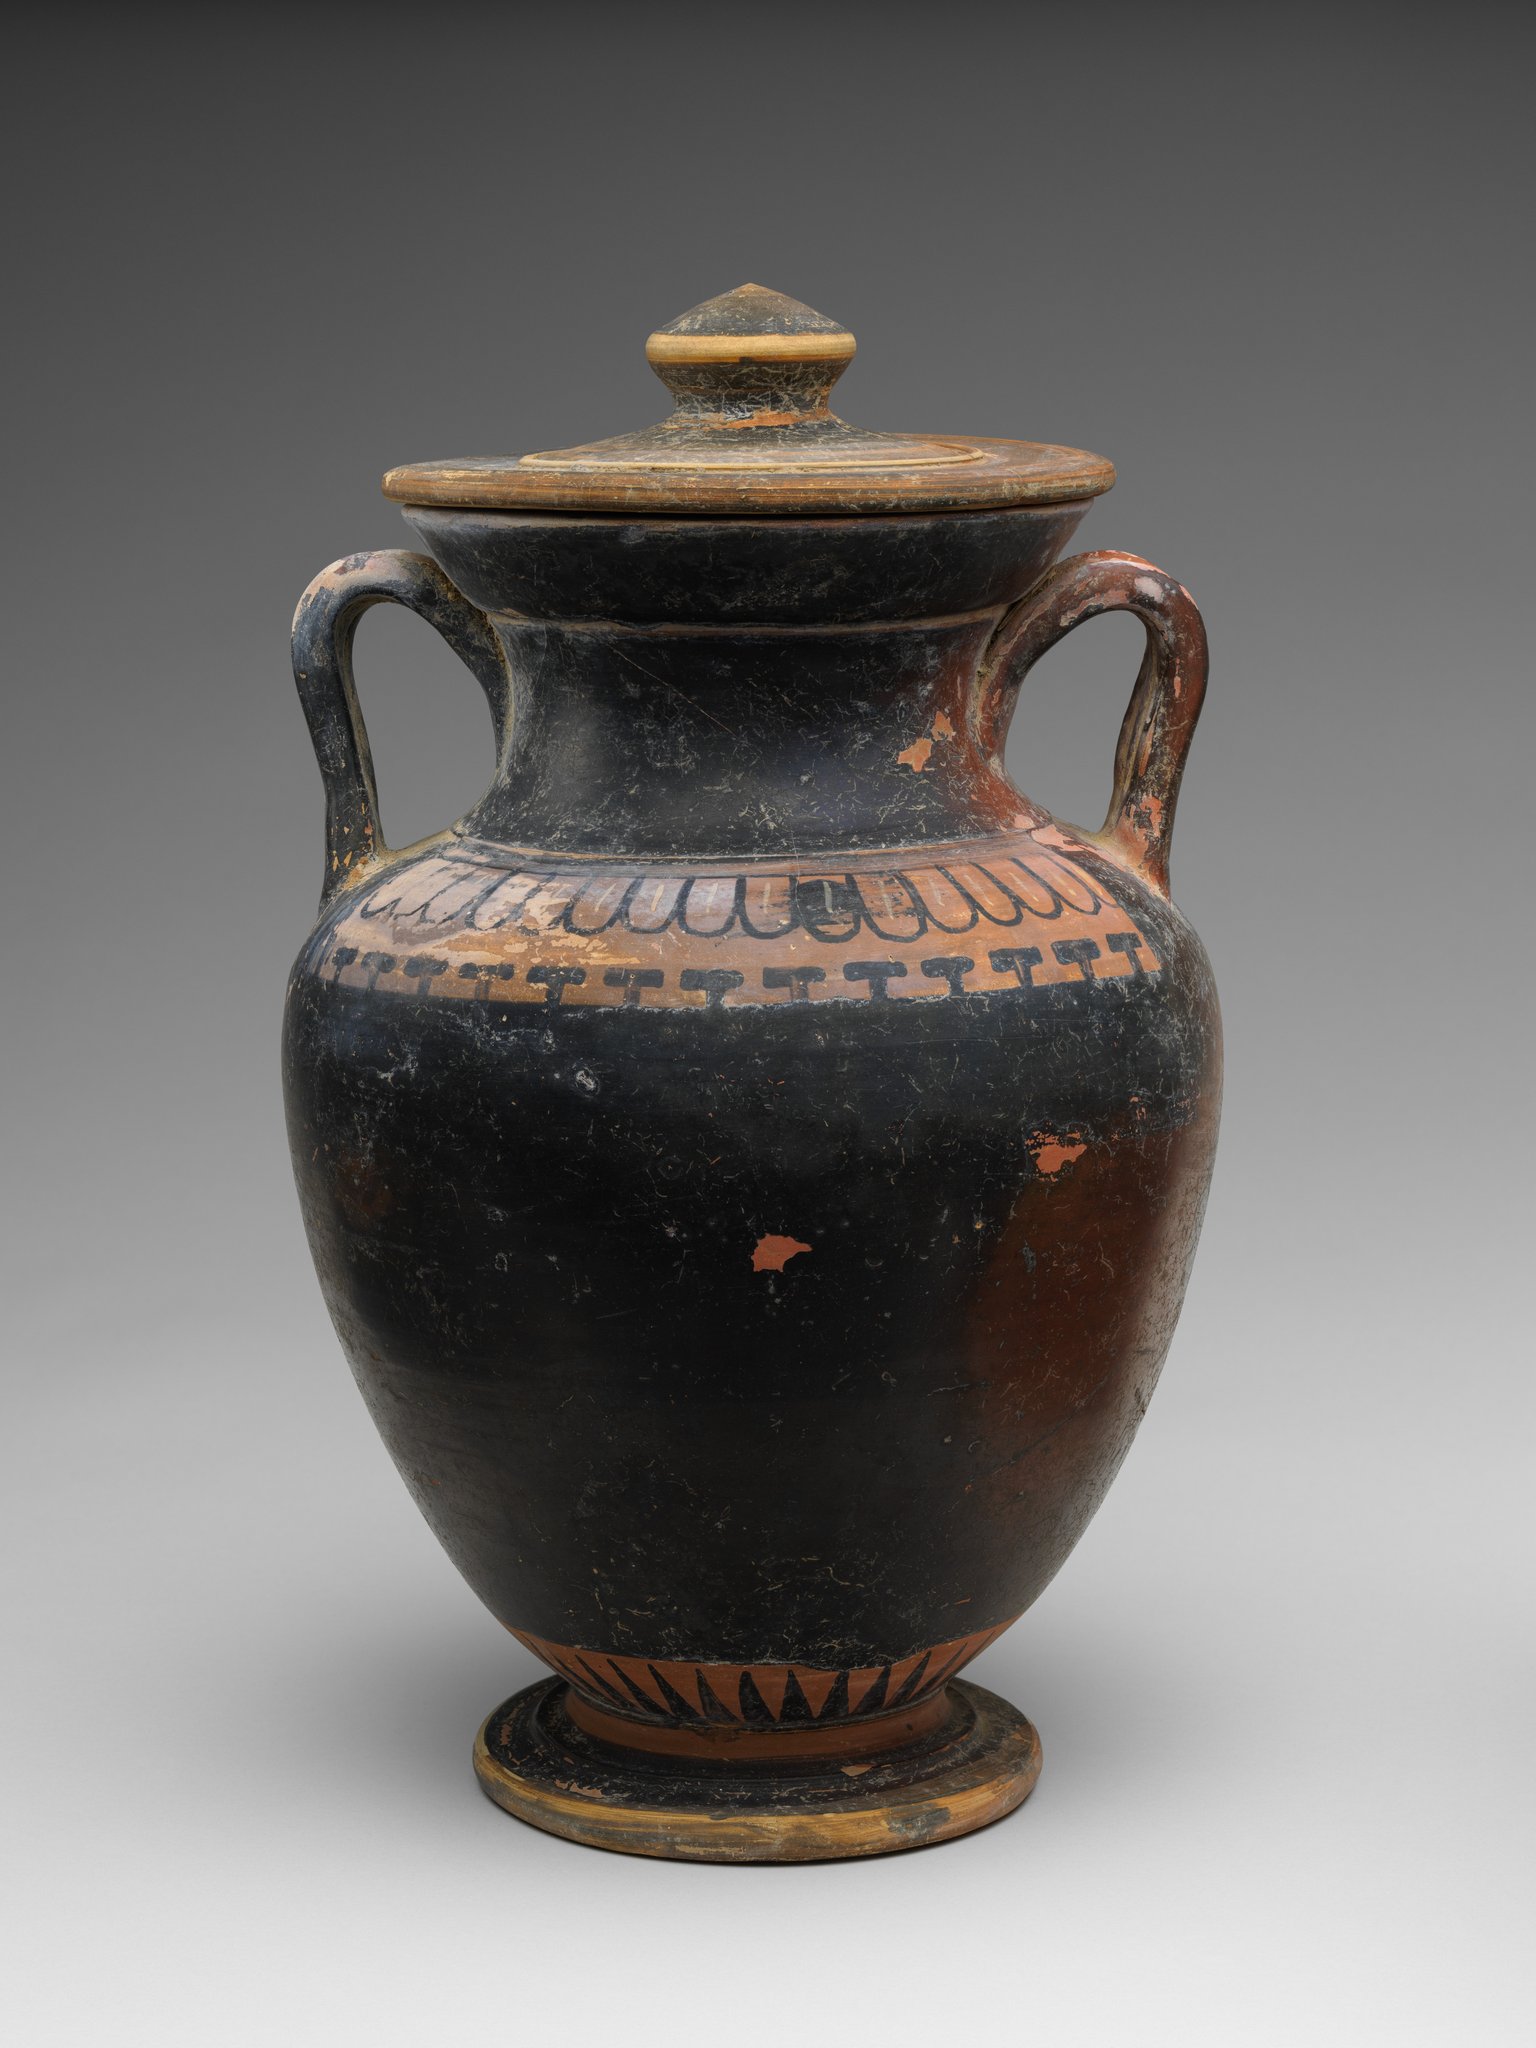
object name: neck amphora with lid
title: Neck-amphora with lid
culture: italic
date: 600-401 BCE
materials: terracotta